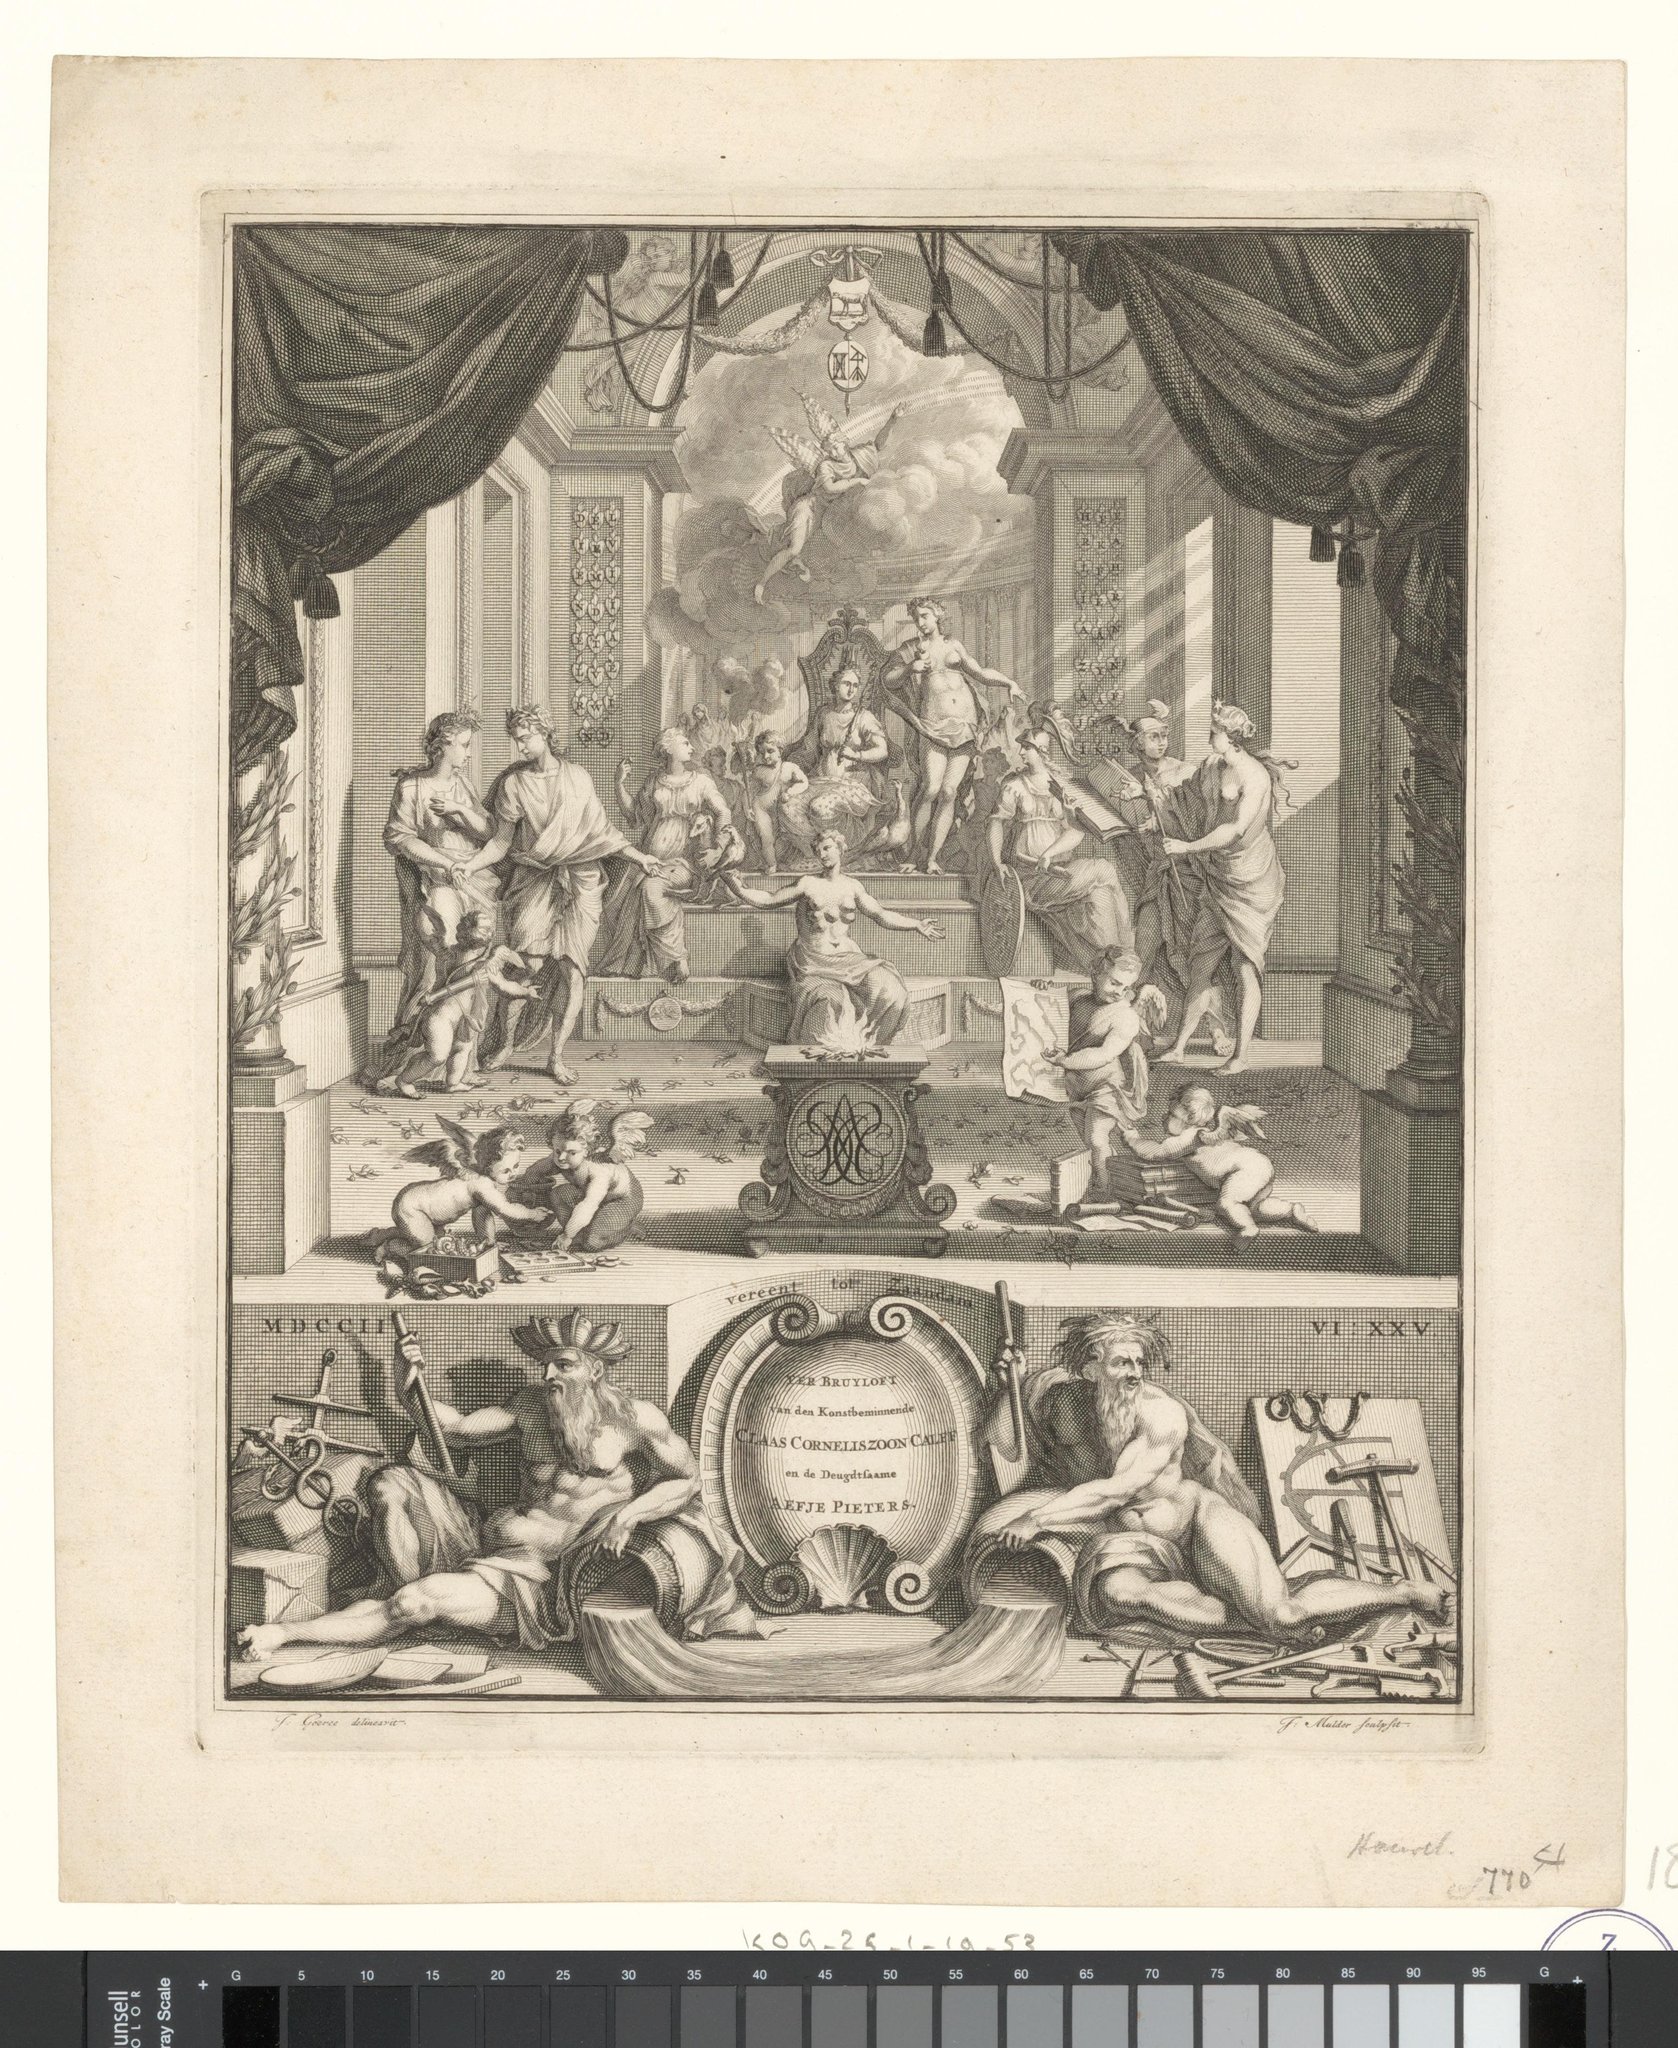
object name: print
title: Bruiloftsprent van Claas Corneliszoon Calff en Aefje Pieters, 1702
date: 1702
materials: paper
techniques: engraving, etching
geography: netherlands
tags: (civil) marriage ceremonies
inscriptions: collector's mark, collector's mark: Lugt 1641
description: Bruiloftsprent van Claas Corneliszoon Calff en Aefje Pieters, 25 juni 1702. Allegorische voorstelling van een huwelijk waarin het bruidspaar binnentreedt in een zaal met Venus op de troon, omringd door andere goden en personificaties. Onderwerpsrubrieken binnen de Atlas Zeden en Gewoonten: Des Menschen Begin, Midden en Einde. Bruiloft en huwelijk.